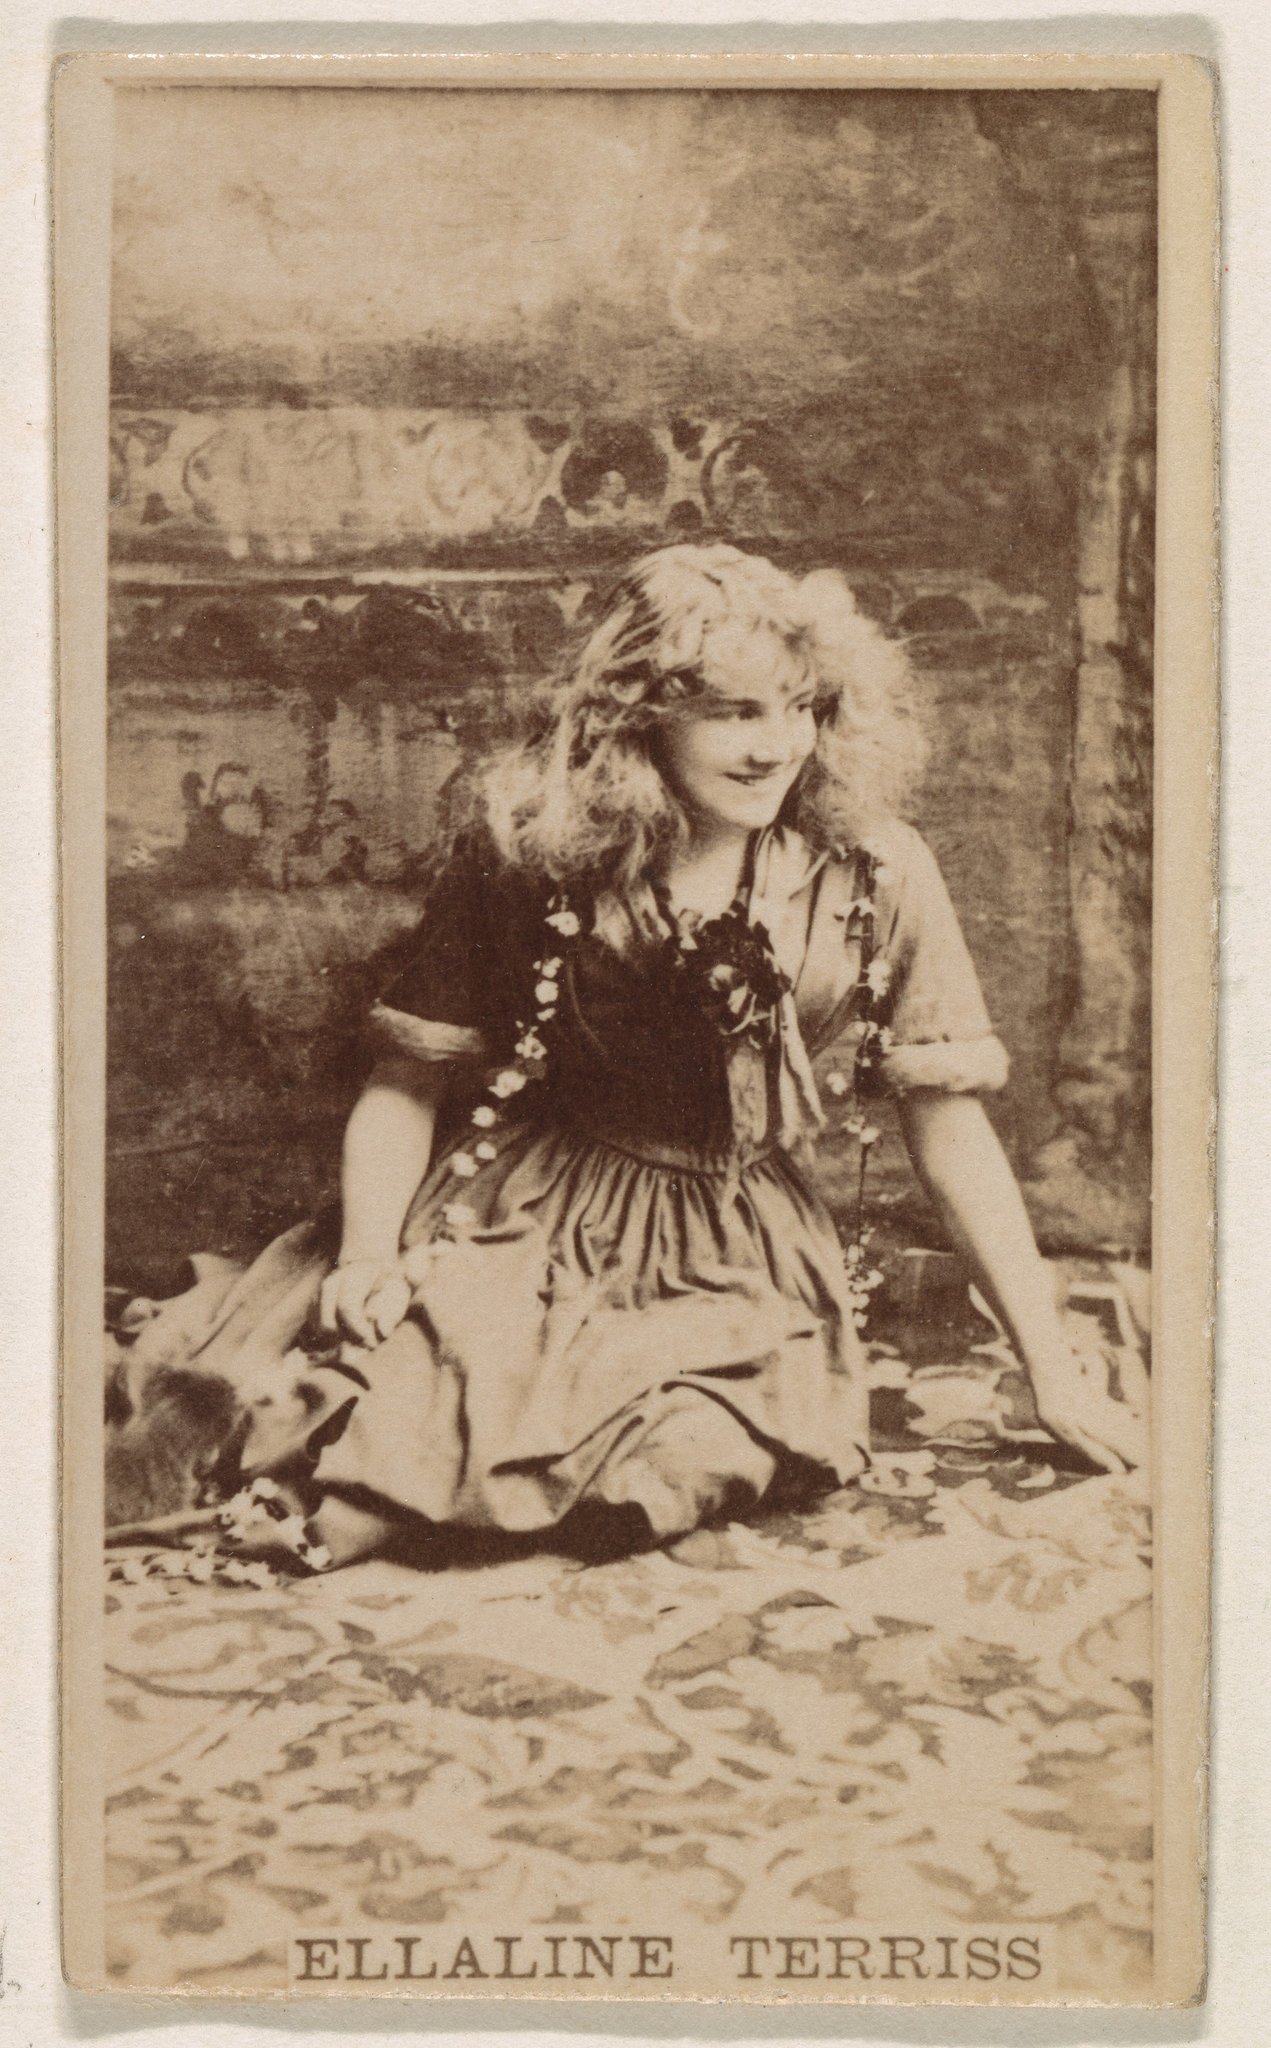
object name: photograph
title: Ellaline Terriss, from the Actresses series (N245) issued by Kinney Brothers to promote Sweet Caporal Cigarettes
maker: kinney brothers tobacco company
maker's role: publisher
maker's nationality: american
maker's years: 1869-2011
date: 1890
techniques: albumen silver print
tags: portraits,women,actresses